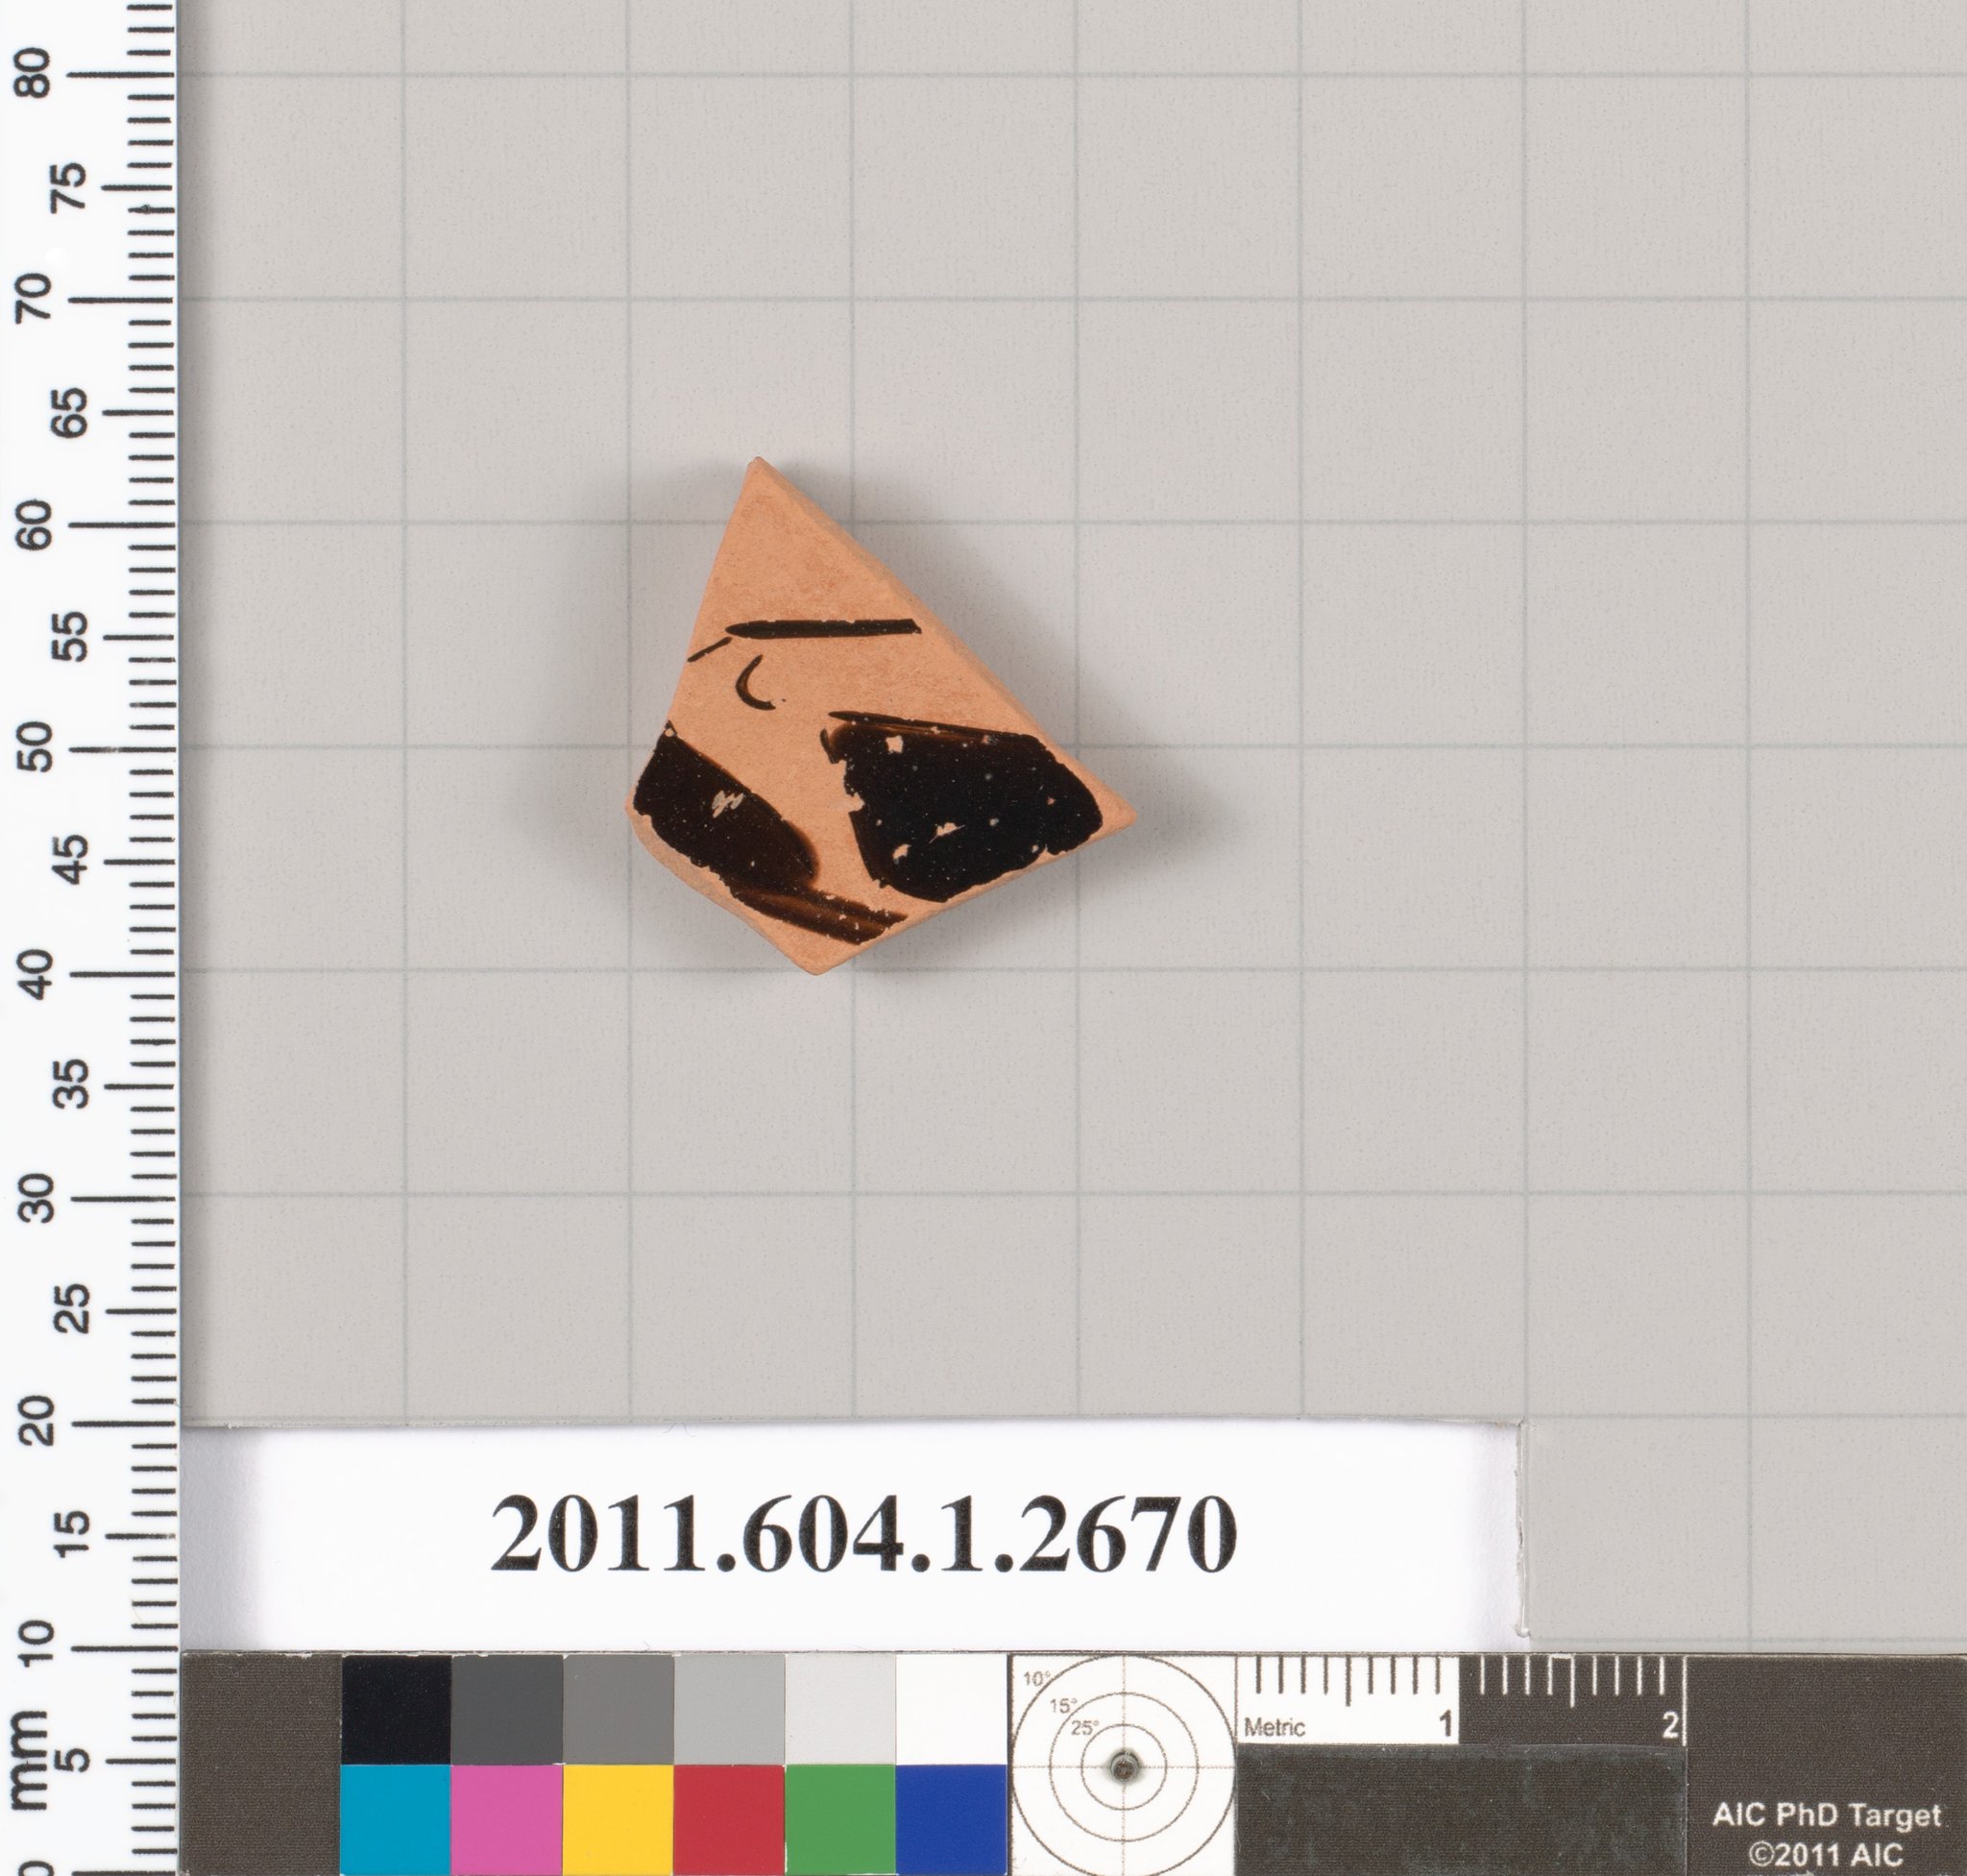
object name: kylix fragment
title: Terracotta fragment of a kylix (drinking cup)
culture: greek, attic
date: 520-500 BCE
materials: terracotta